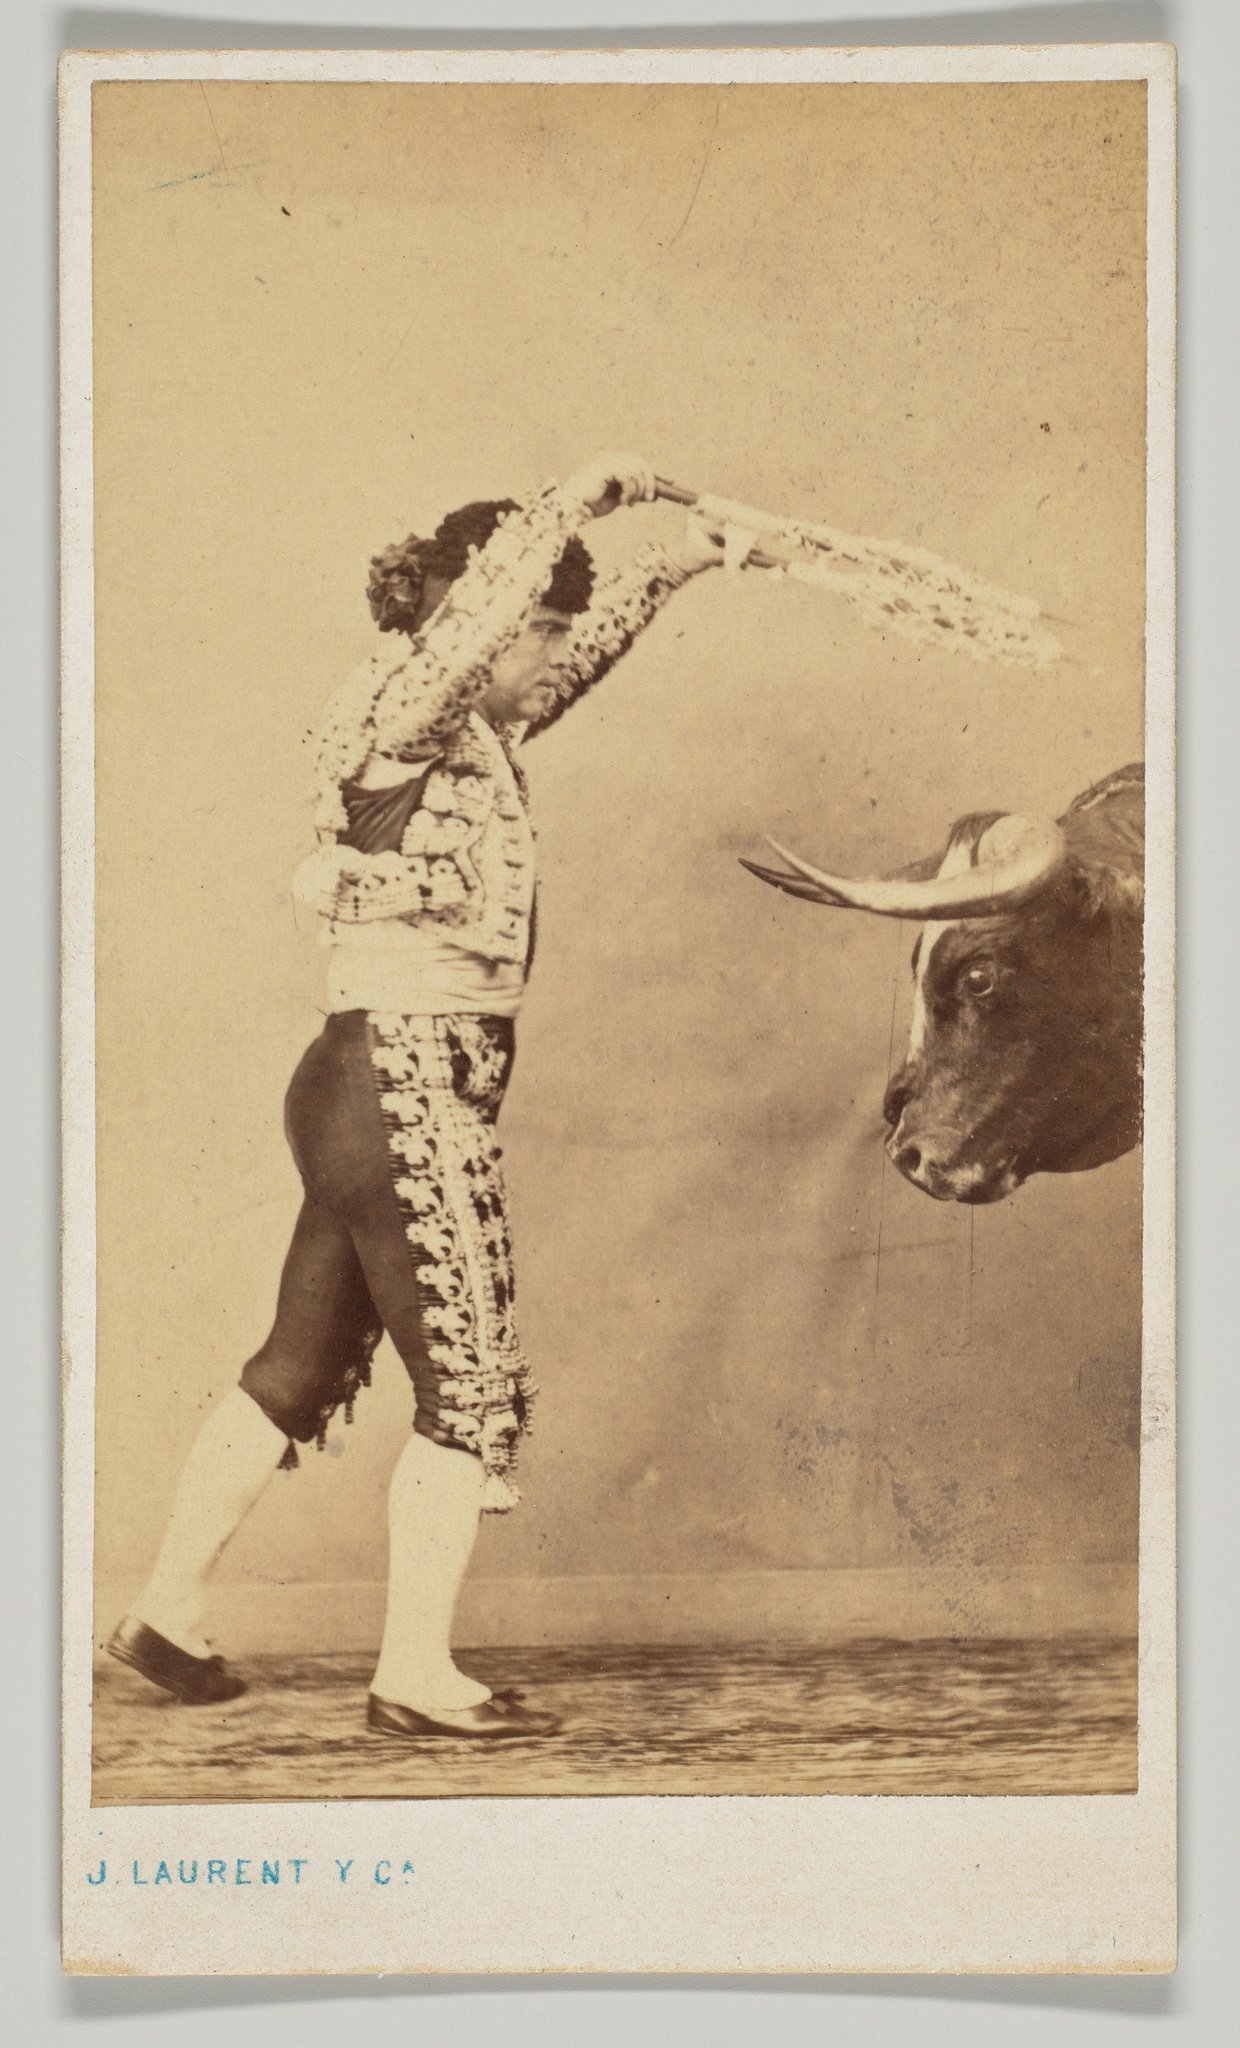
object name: photograph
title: [Matador with Bull]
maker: juan laurent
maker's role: publisher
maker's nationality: french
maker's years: 1816-1896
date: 1860-1869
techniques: albumen silver print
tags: men,portraits,bulls